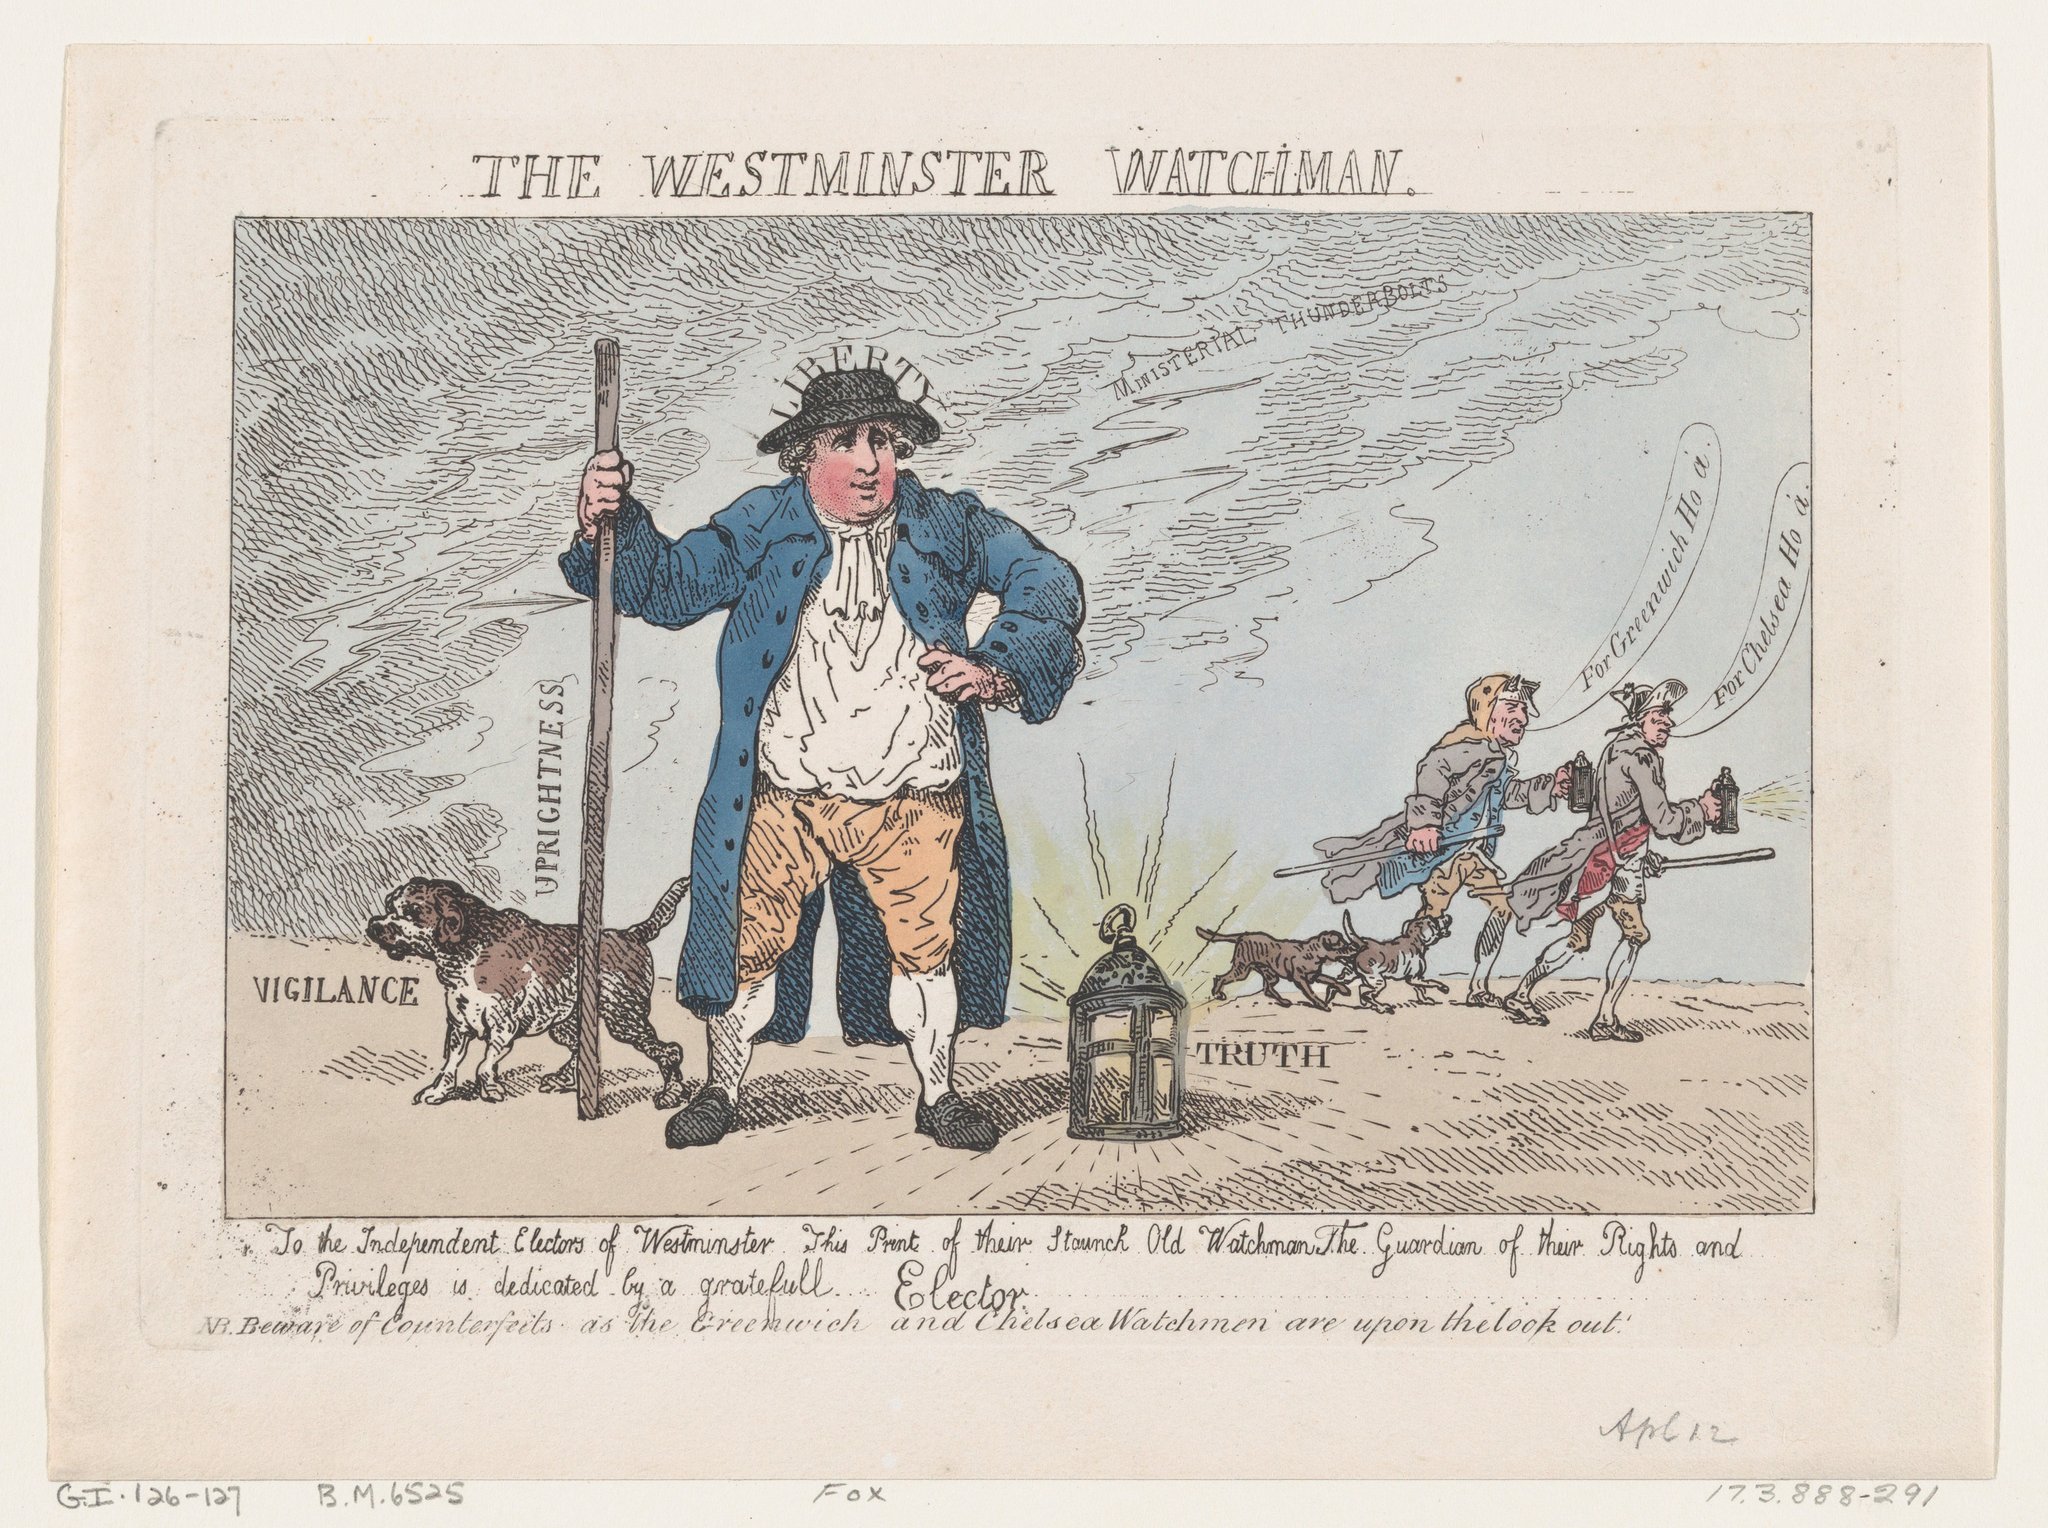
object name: print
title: The Westminster Watchman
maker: thomas rowlandson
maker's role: artist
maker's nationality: british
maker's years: 1757-1827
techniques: etching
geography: london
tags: satire,men,dogs,clouds,lamps